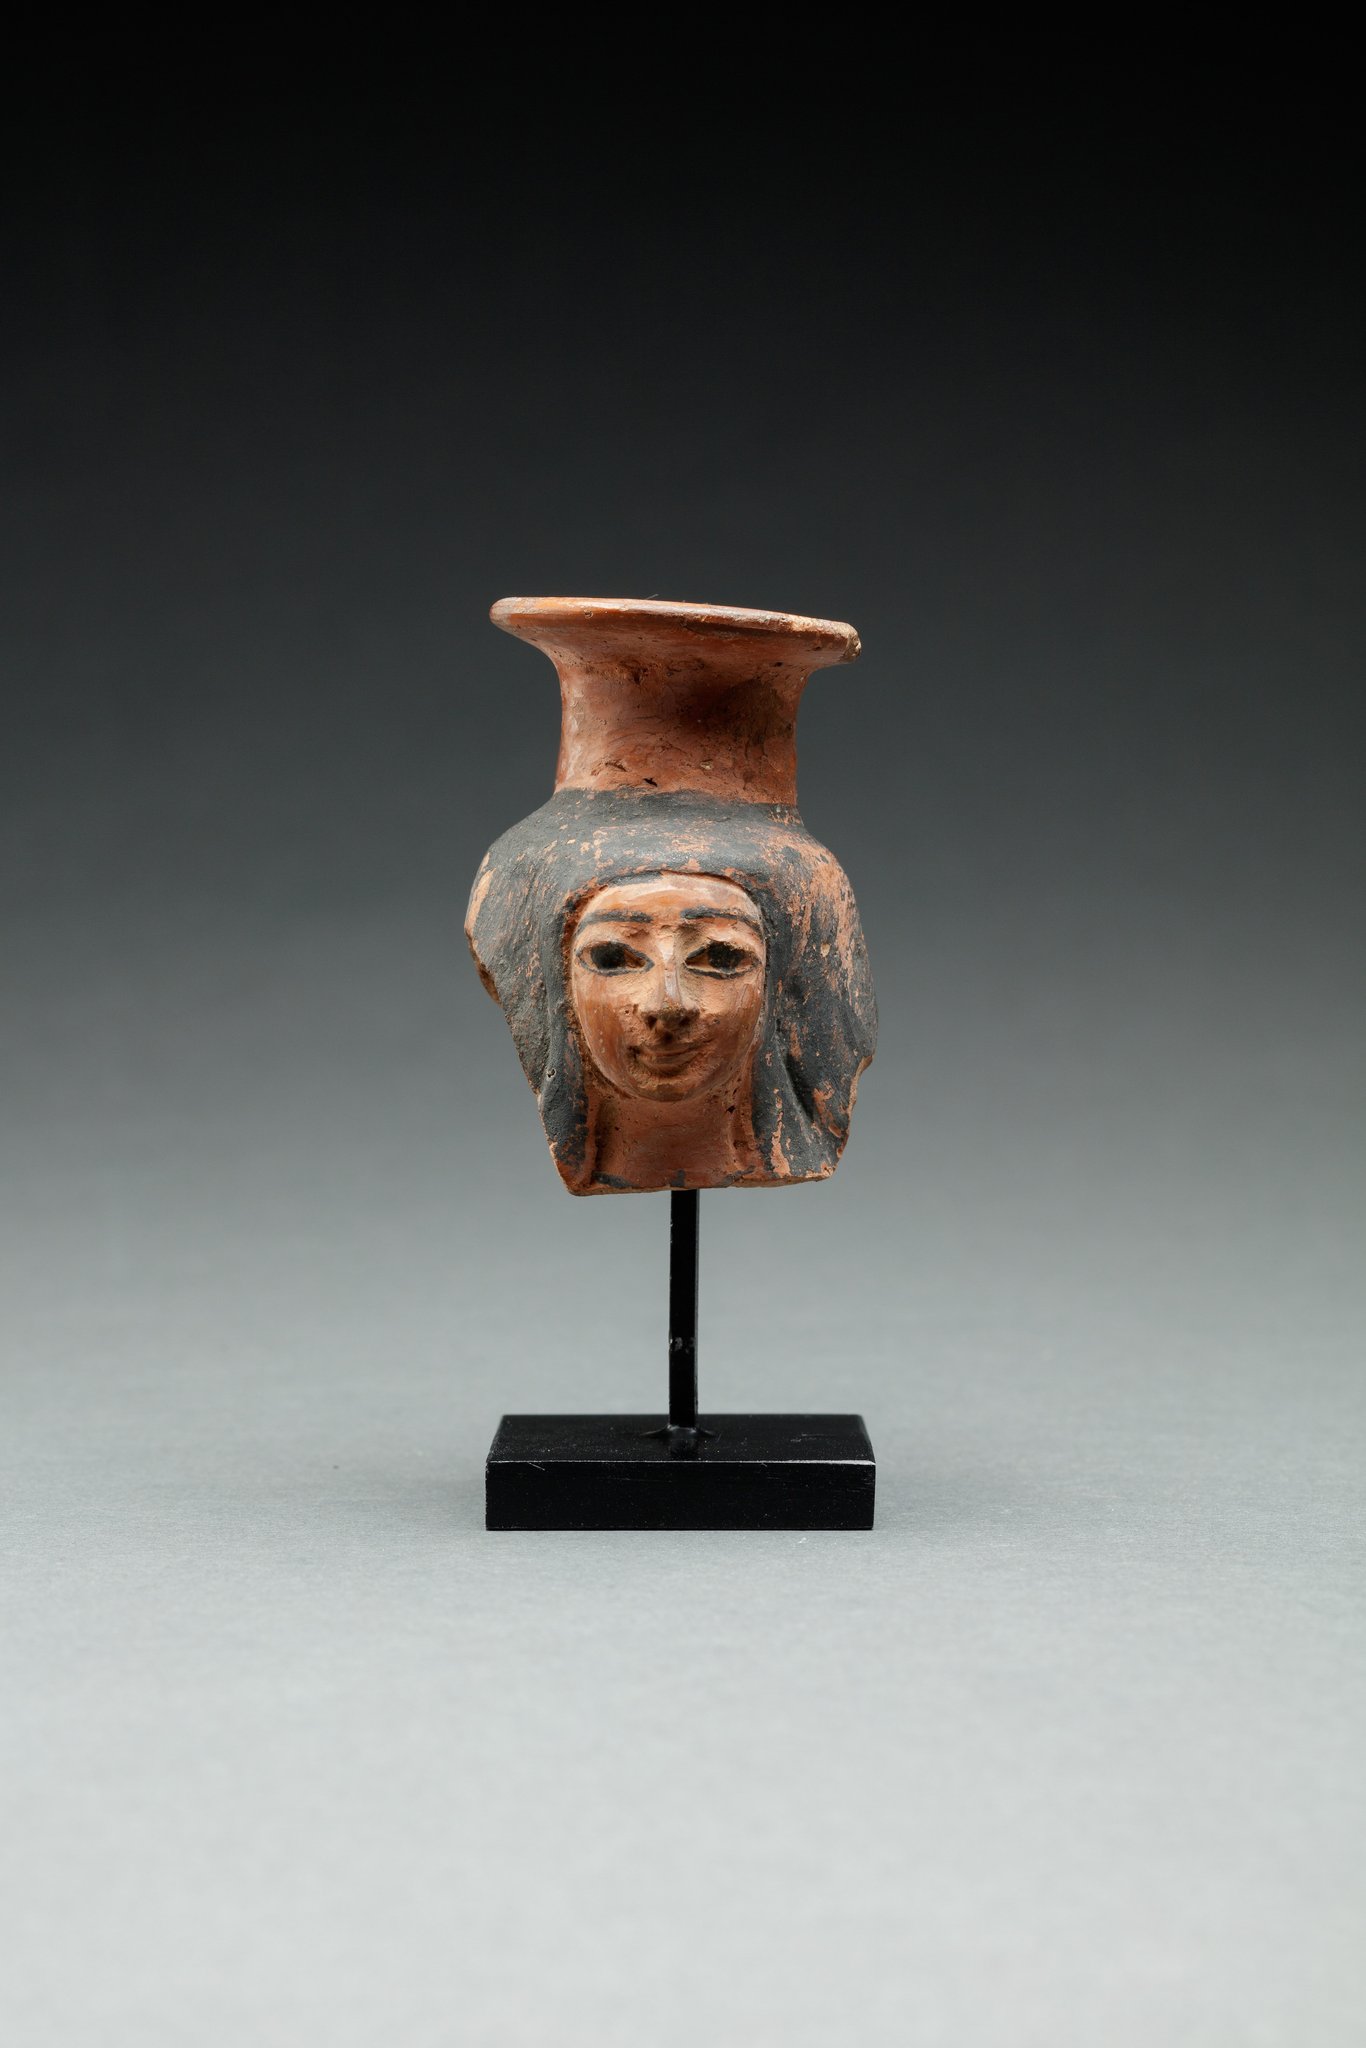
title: Upper Part of a Jar in the Shape of a Woman’s Head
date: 1479-1352 BCE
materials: paint, pottery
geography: egypt